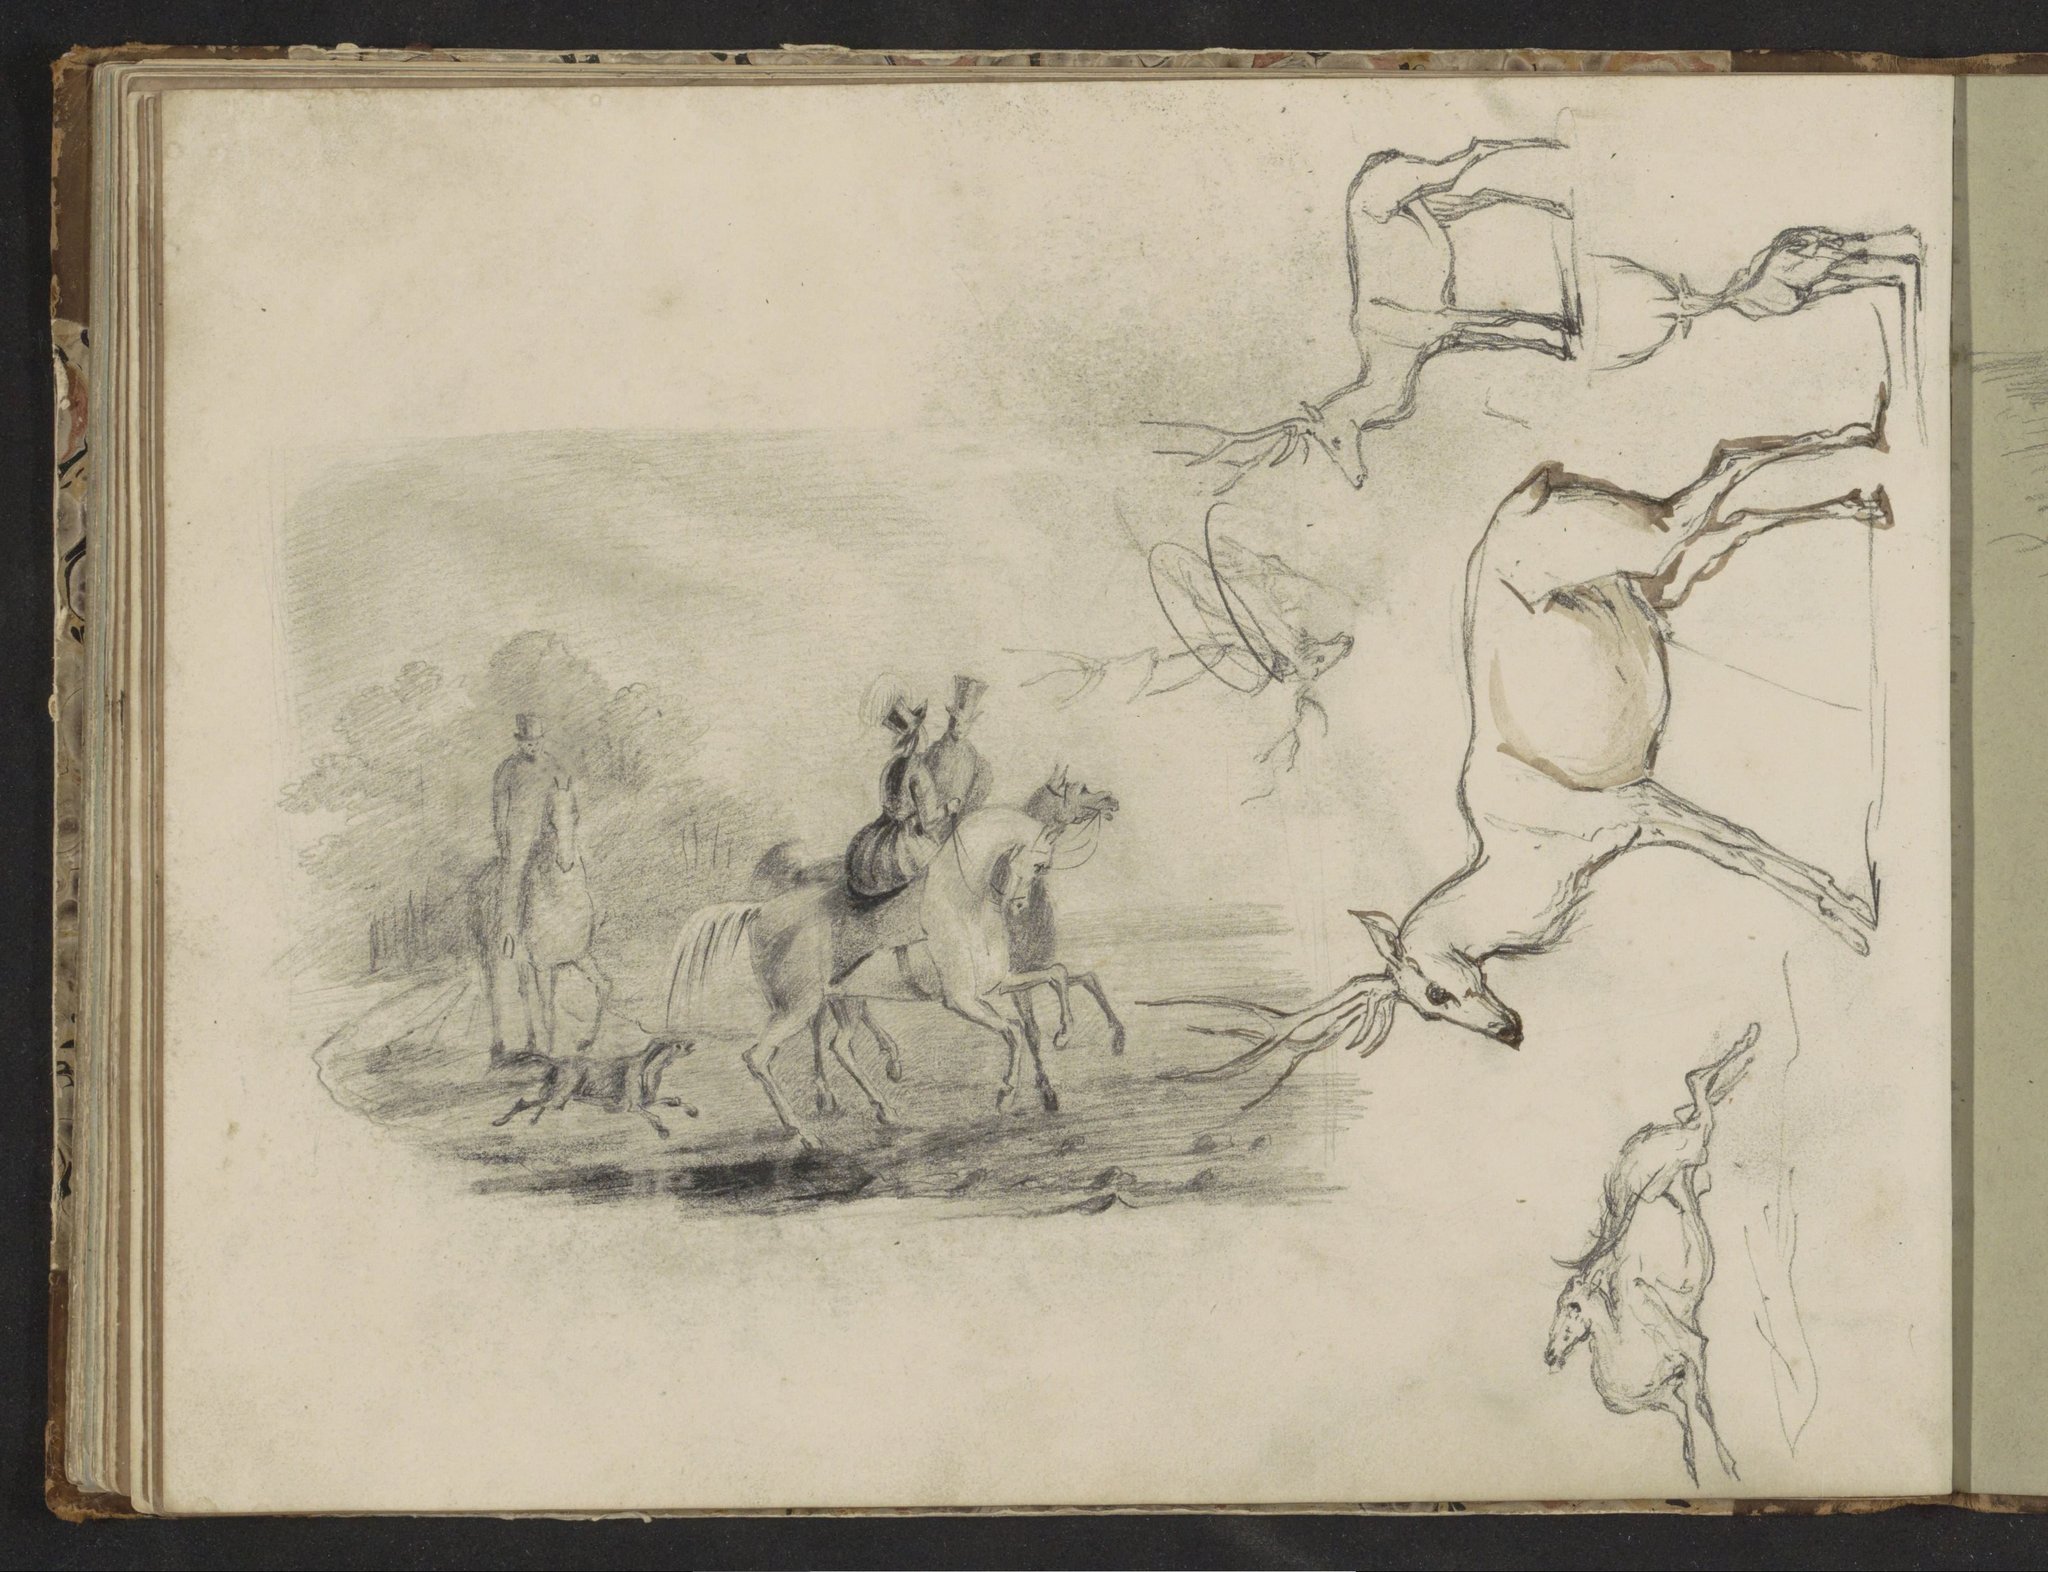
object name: sketchbook leaf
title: Landschap met twee mannen en één vrouw te paard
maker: johannes tavenraat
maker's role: draughtsman, painter, print maker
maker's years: 1809-1881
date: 1833-1841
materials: ink, paper, pencil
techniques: brush, pen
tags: riding a horse, ass, or mule; rider, horseman, hoofed animals: deer, landscapes (+ landscape with figures, staffage)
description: Tevens studies van herten. Blad 32 verso uit een schetsboek met 41 bladen.